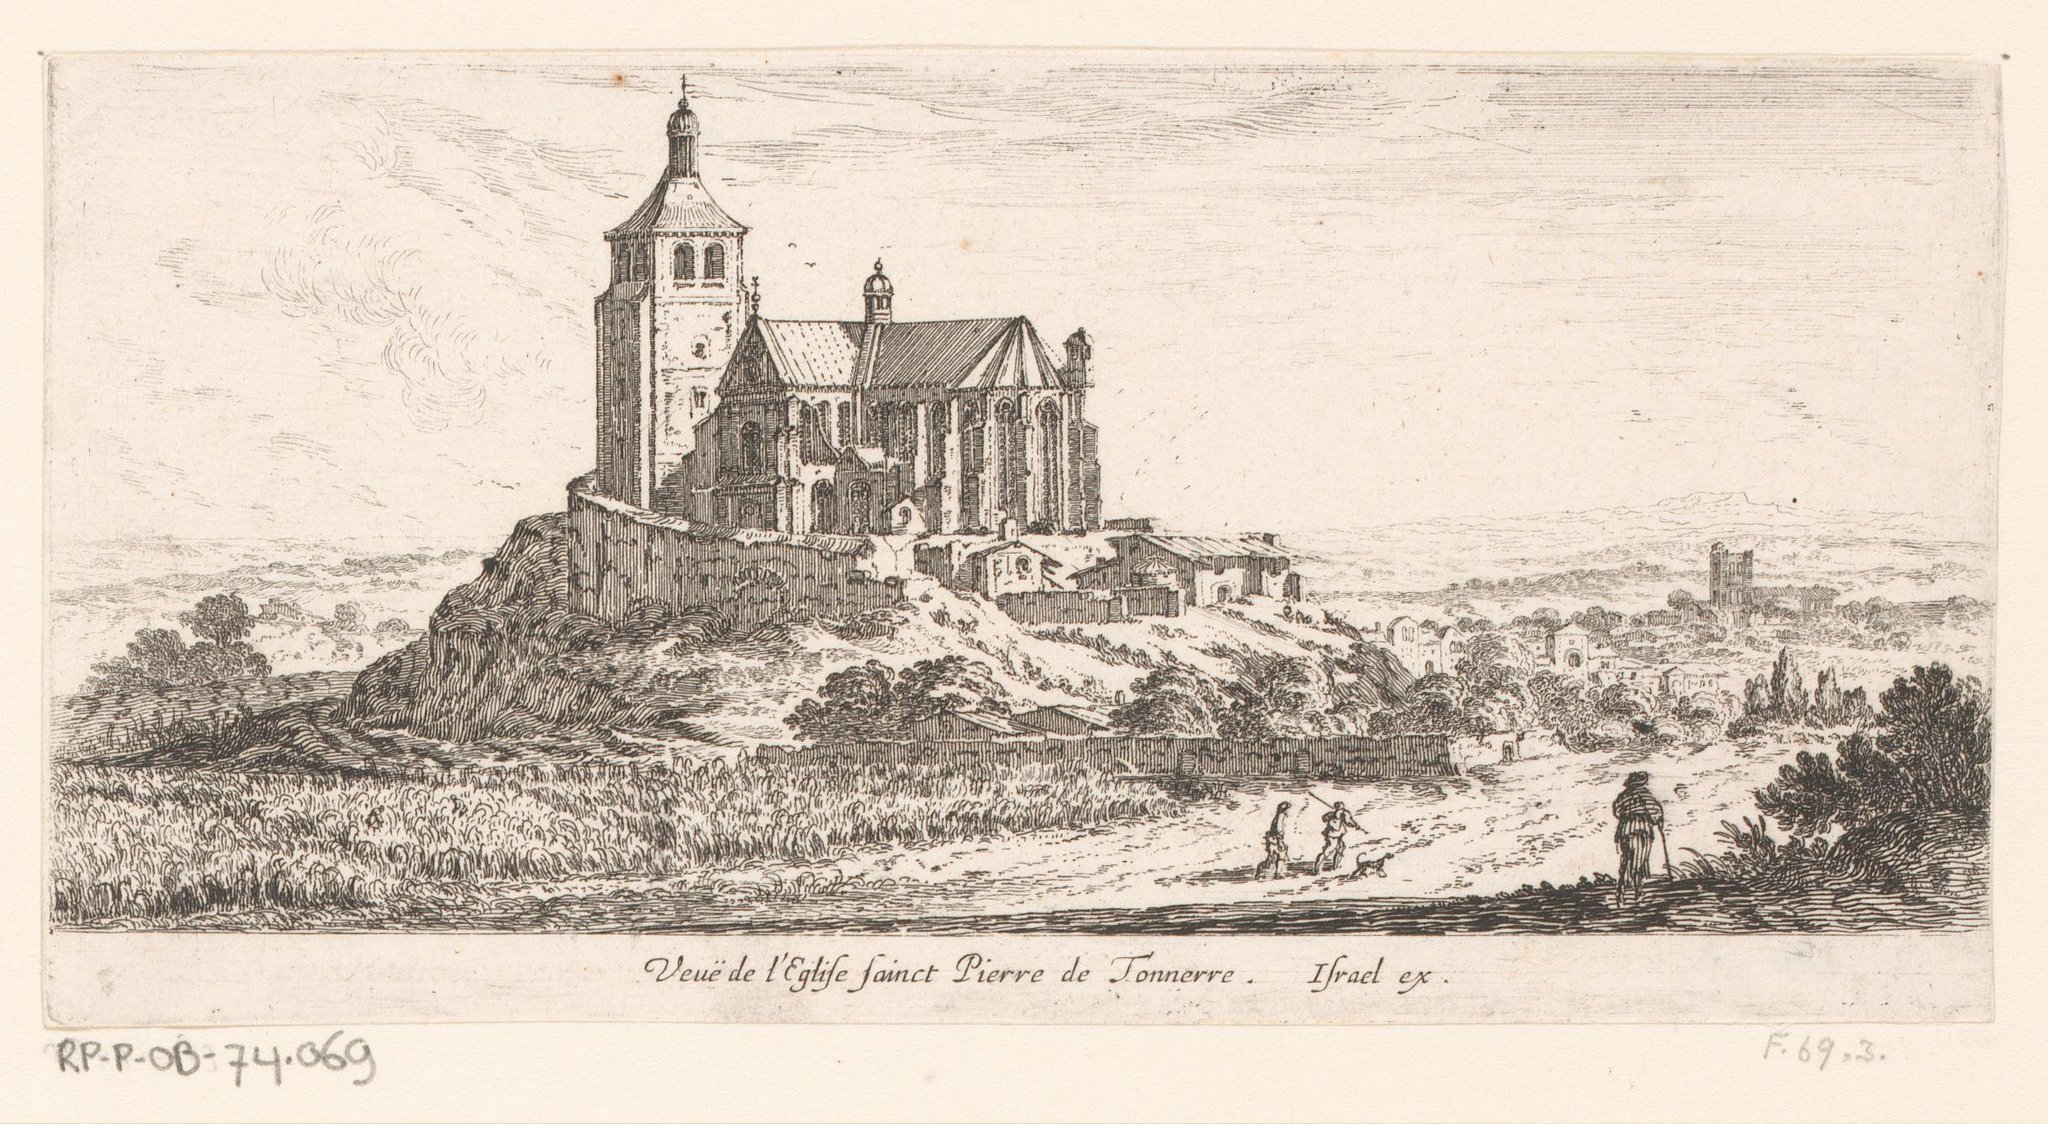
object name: print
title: Gezicht op de kerk van Saint-Pierre in Tonnerre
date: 1650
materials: paper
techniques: etching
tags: landscape with tower or castle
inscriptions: collector's mark: Lugt 240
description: Prent maakt deel uit van een ongenummerde serie van twaalf prenten.